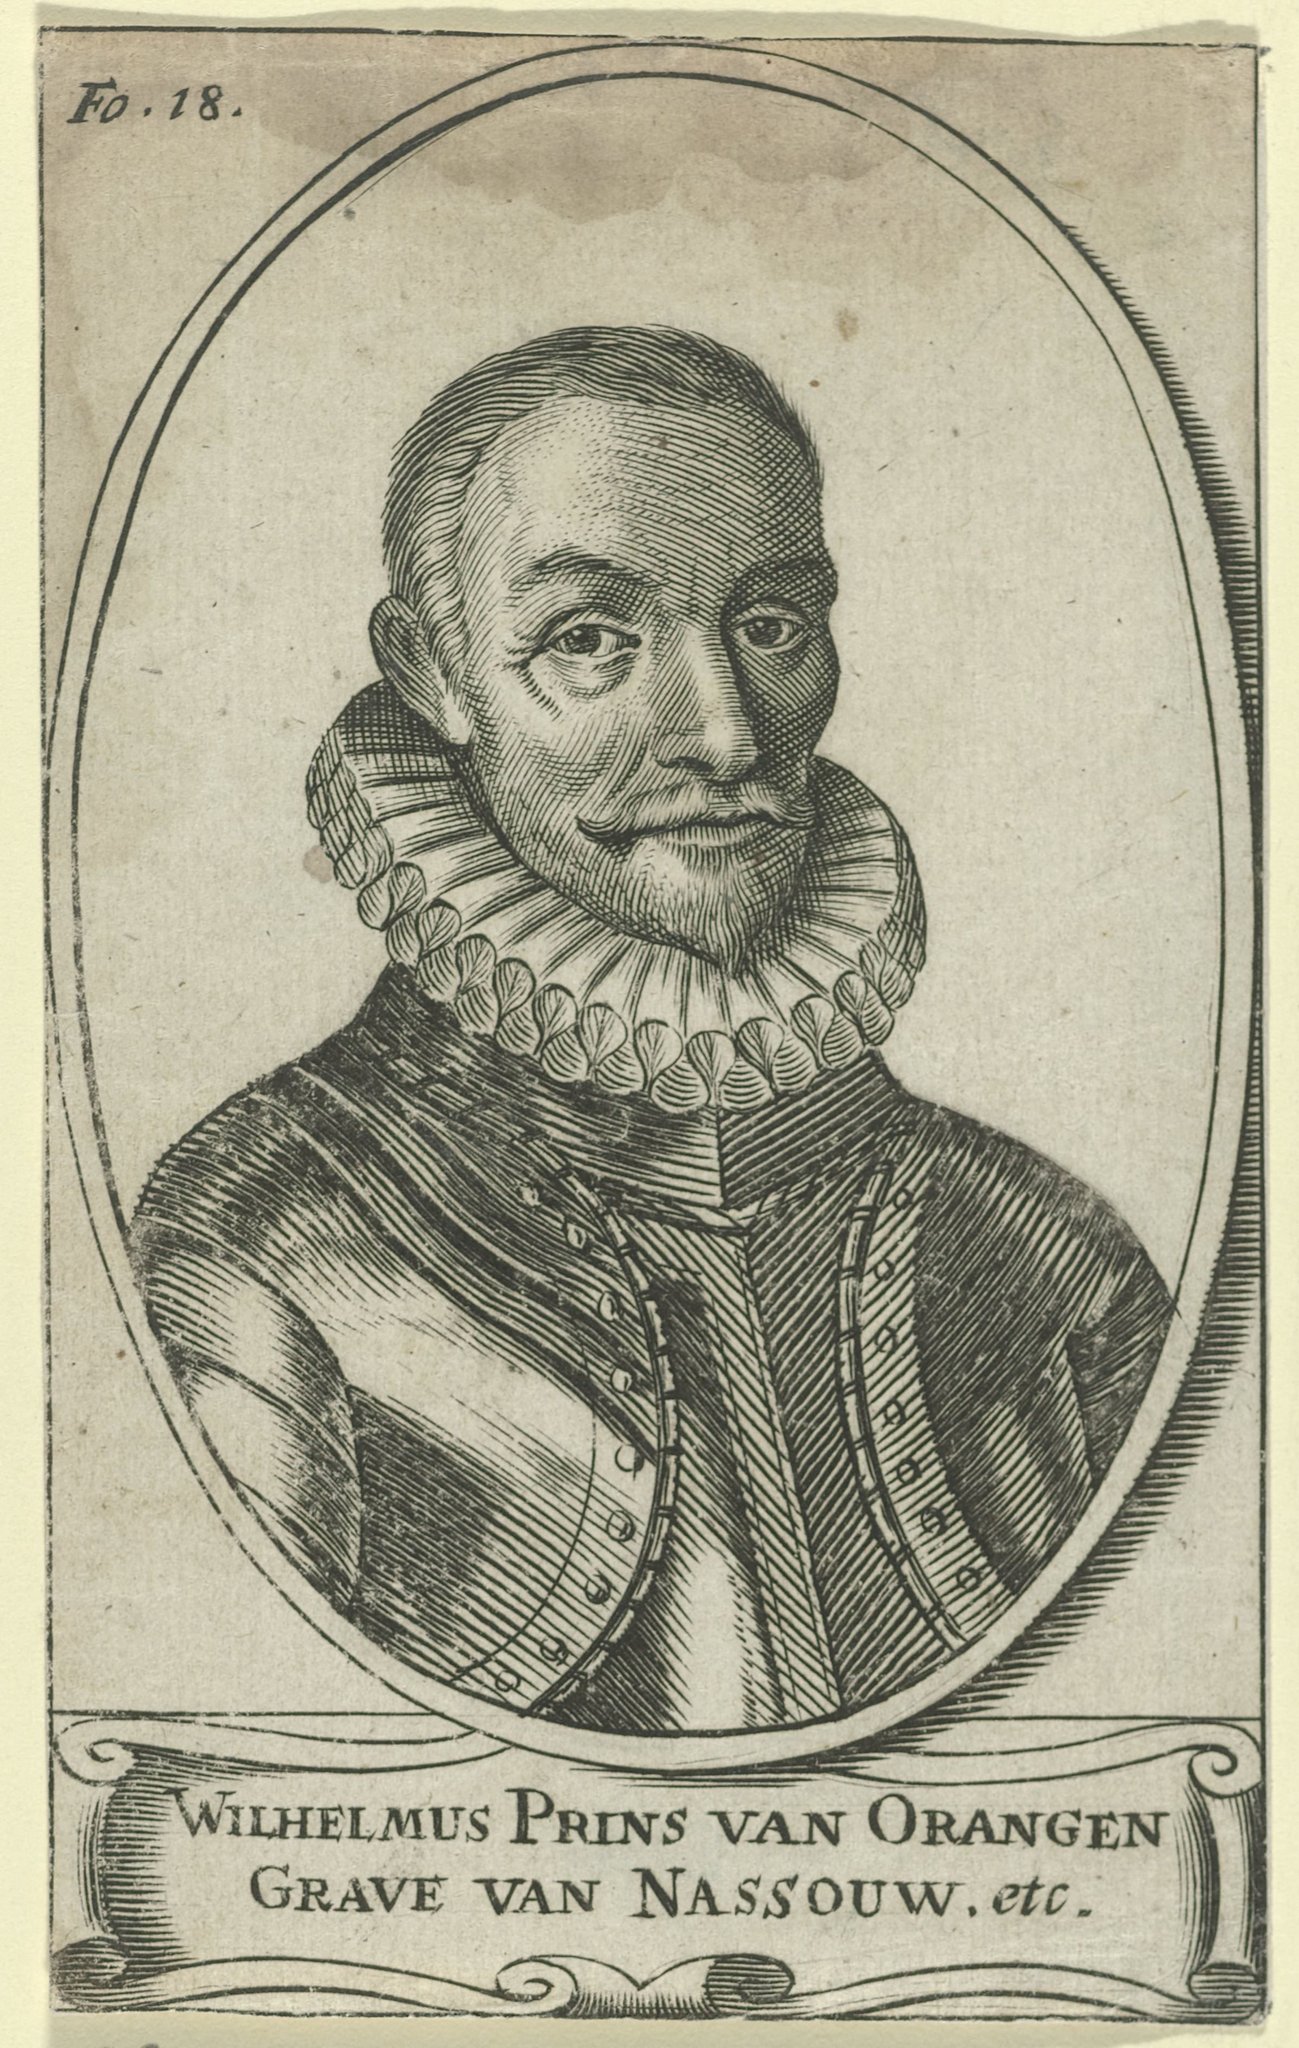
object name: print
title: Portret van Willem I, prins van Oranje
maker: Anonymous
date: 1600-1699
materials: paper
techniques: engraving, etching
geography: low countries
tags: delft, william i (prince of orange)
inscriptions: collector's mark: Lugt 2233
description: De hier vermelde titel verwijst naar de hoogst verkregen titel van de geportretteerde, niet per se naar de titel die de geportretteerde op deze voorstelling draagt.